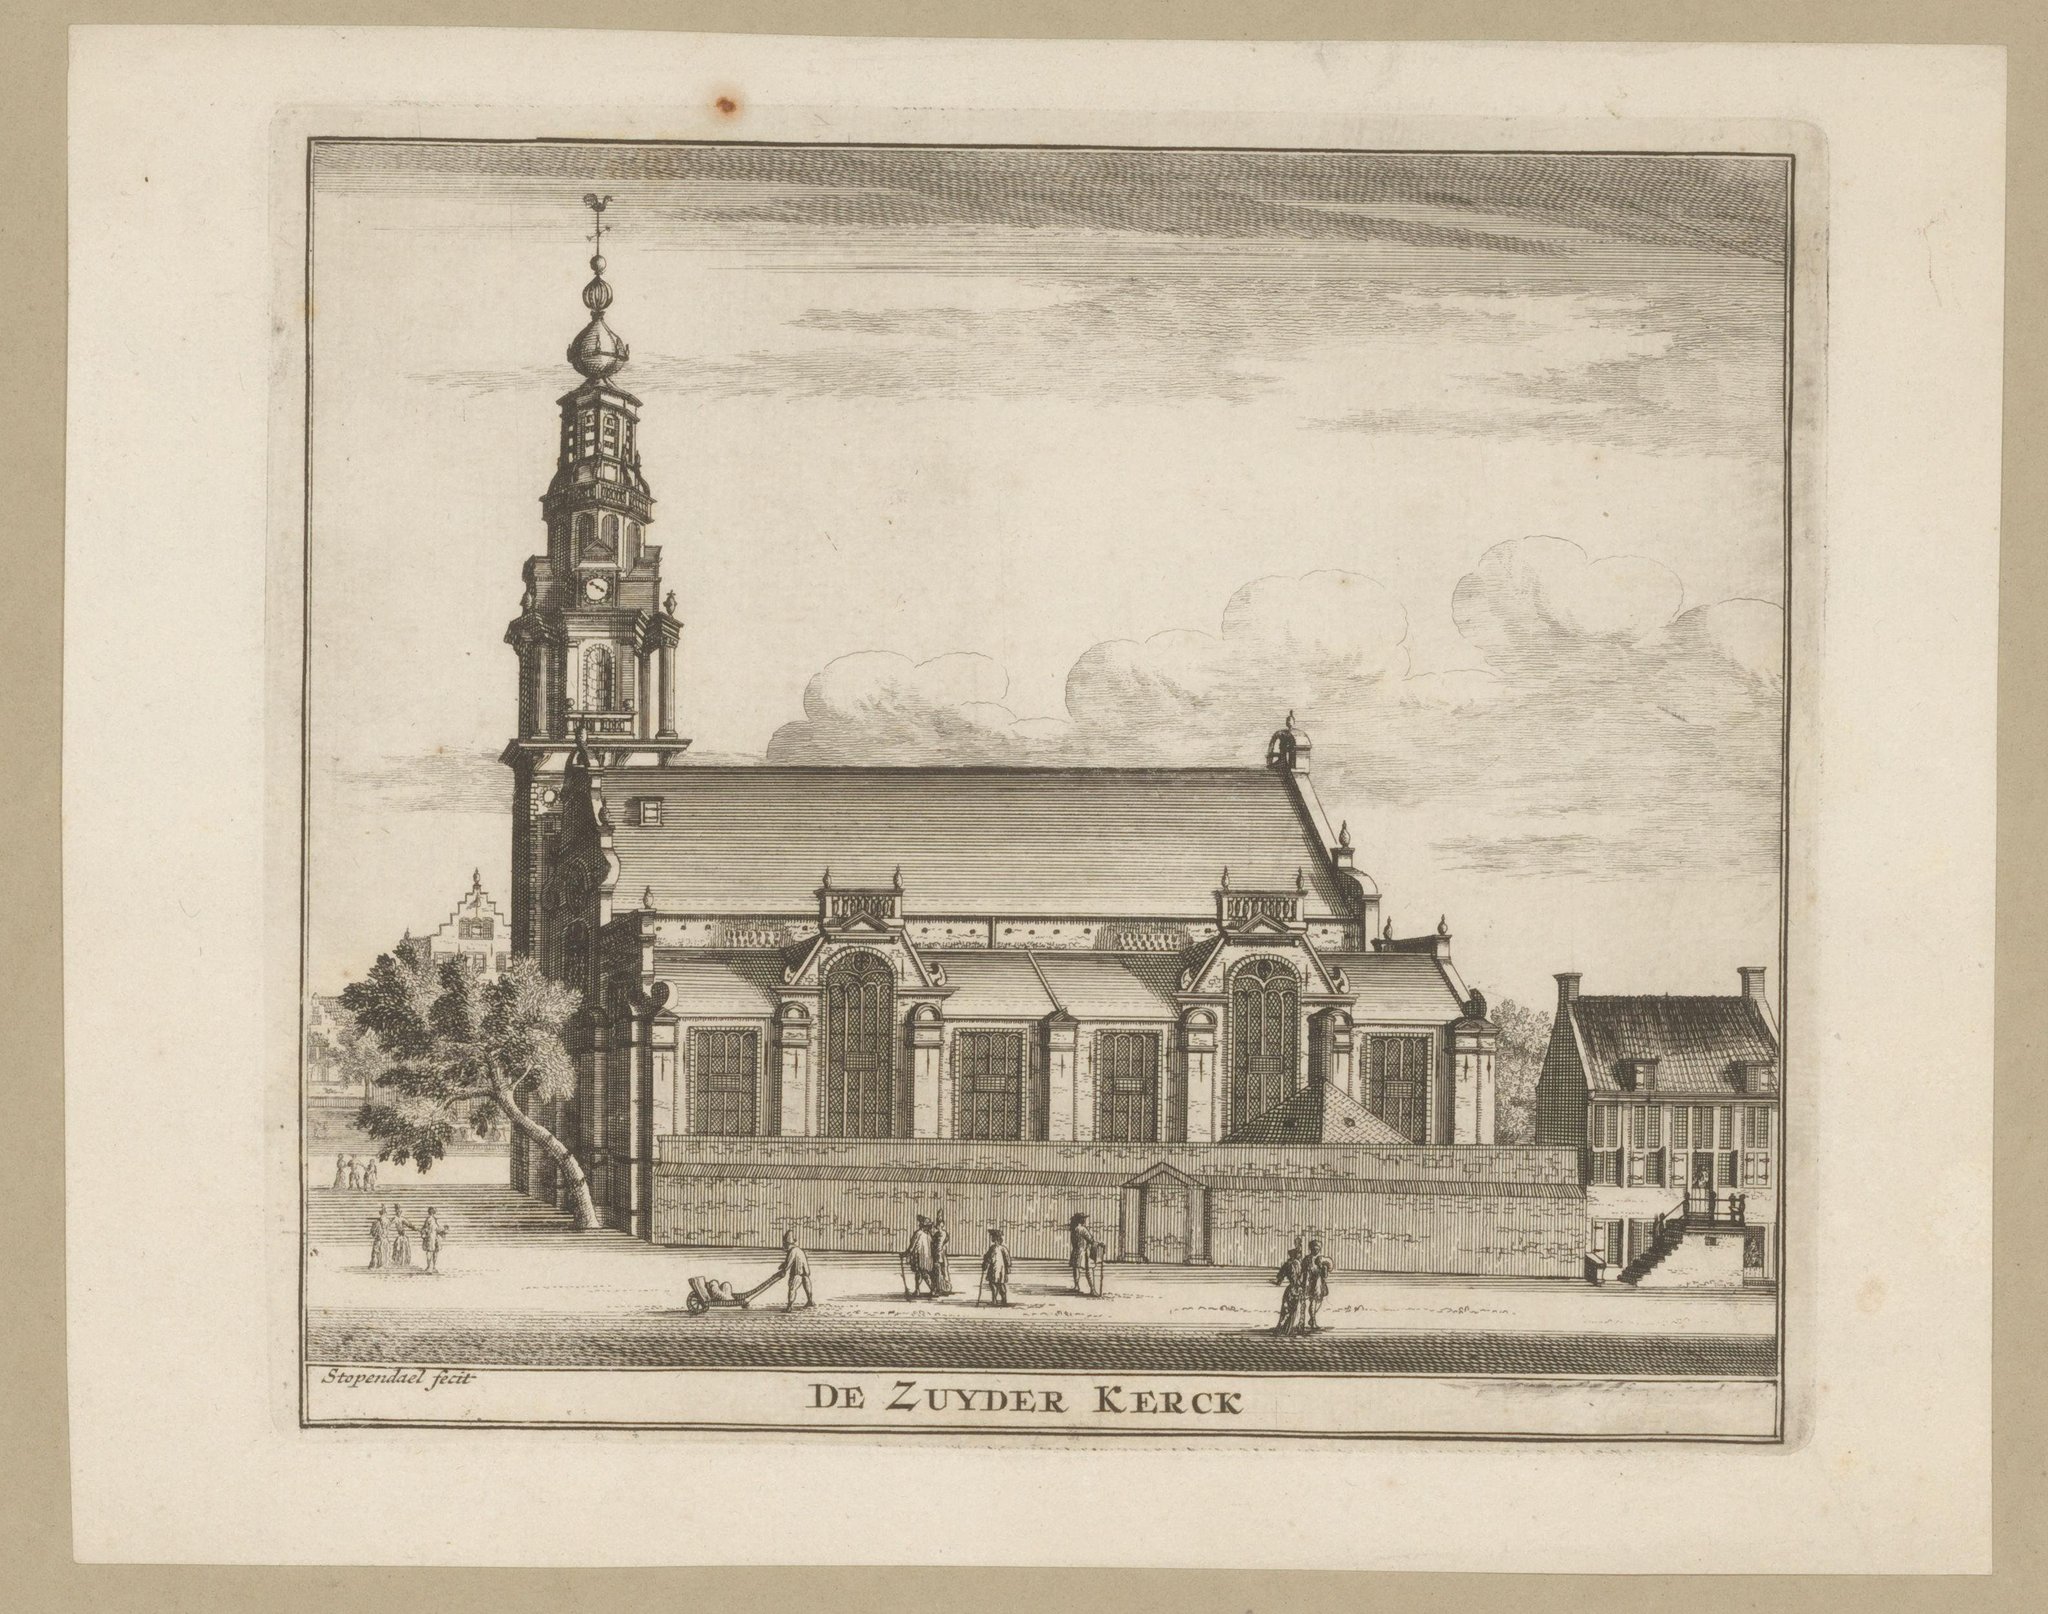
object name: print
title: Gezicht op de Zuiderkerk te Amsterdam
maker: daniël stopendaal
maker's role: print maker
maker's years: 1672-1726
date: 1685-1726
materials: paper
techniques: engraving, etching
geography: amsterdam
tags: church (exterior), street (+ city(-scape) with figures, staffage)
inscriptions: collector's mark: Lugt 1641b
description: Tweede staat van prent (met Franse titel) ook gebruikt in: Description de la fameuse ville d'Amsterdam (...) / Afbeeldinge van de wydt-vermaarde stadt Amsterdam (...). Amsterdam: Hendrik de Leth, [ca. 1740]. Derde staat van prent (rechtsboven gemerkt Pag. 144) ook gebruikt in: Le guide, ou nouvelle description d'Amsterdam (…). Amsterdam: Covens & Mortier & Covens Jr., 1772.